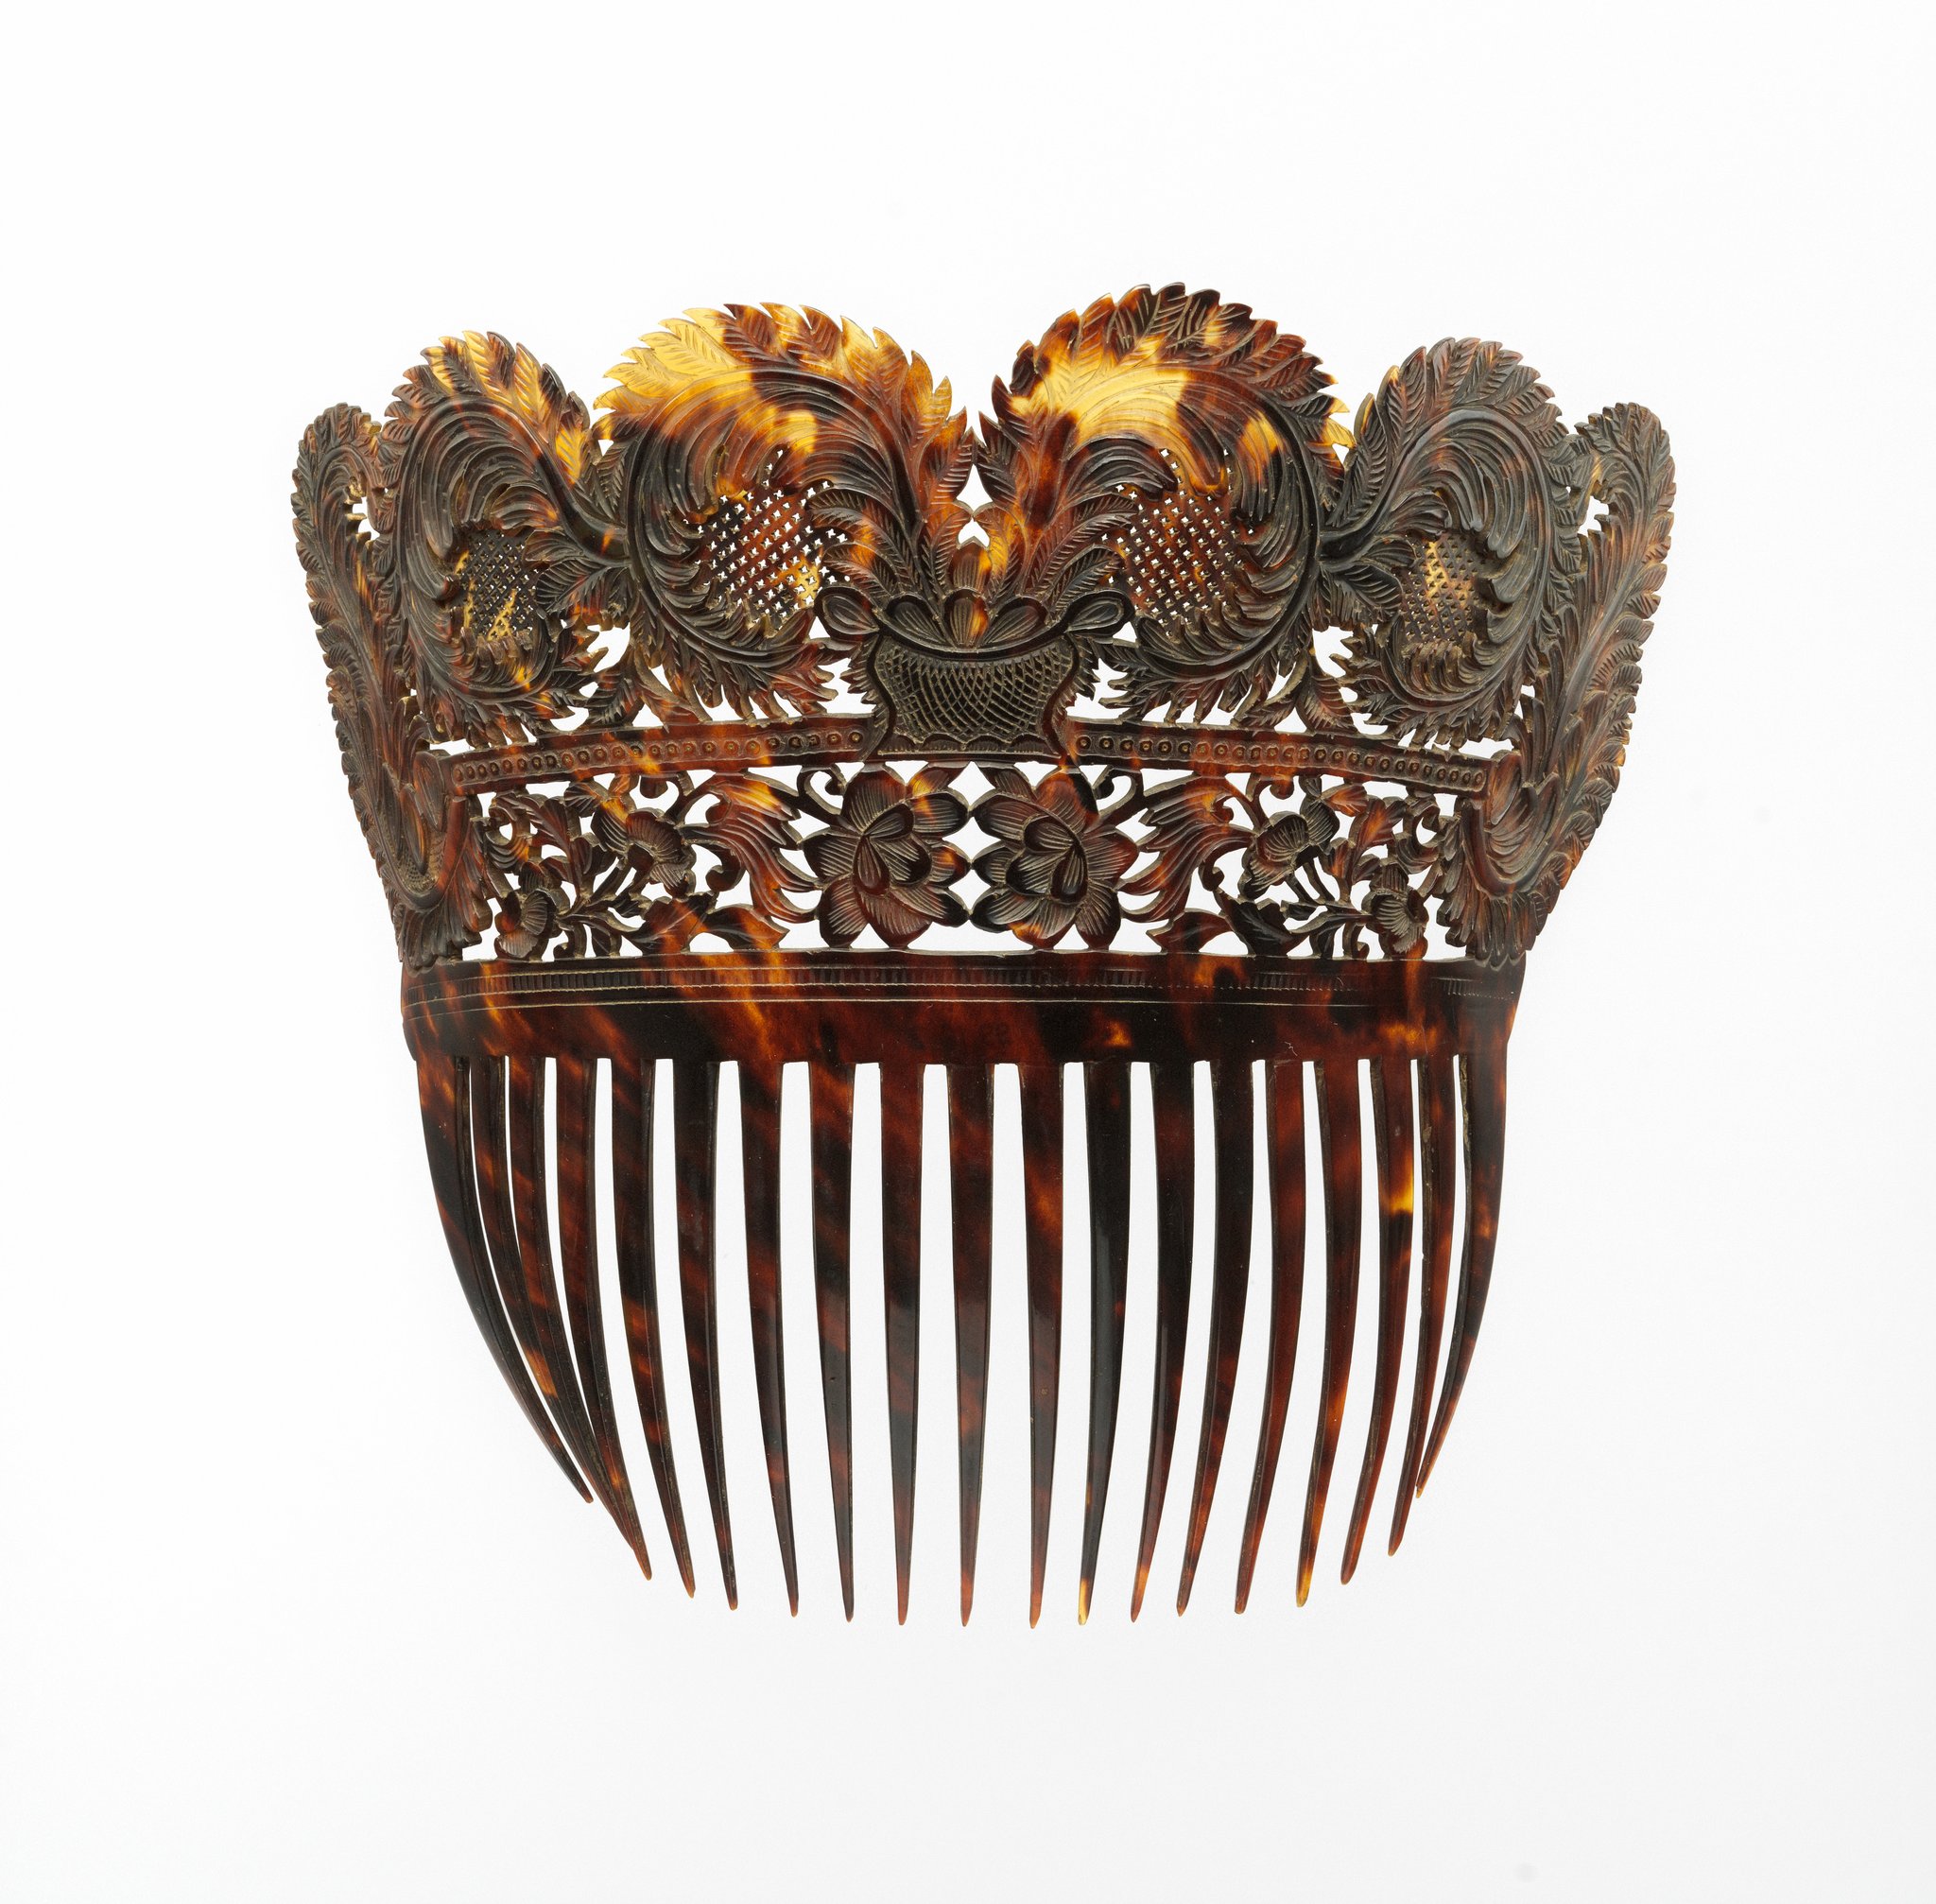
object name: comb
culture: american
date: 1767-1800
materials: shell